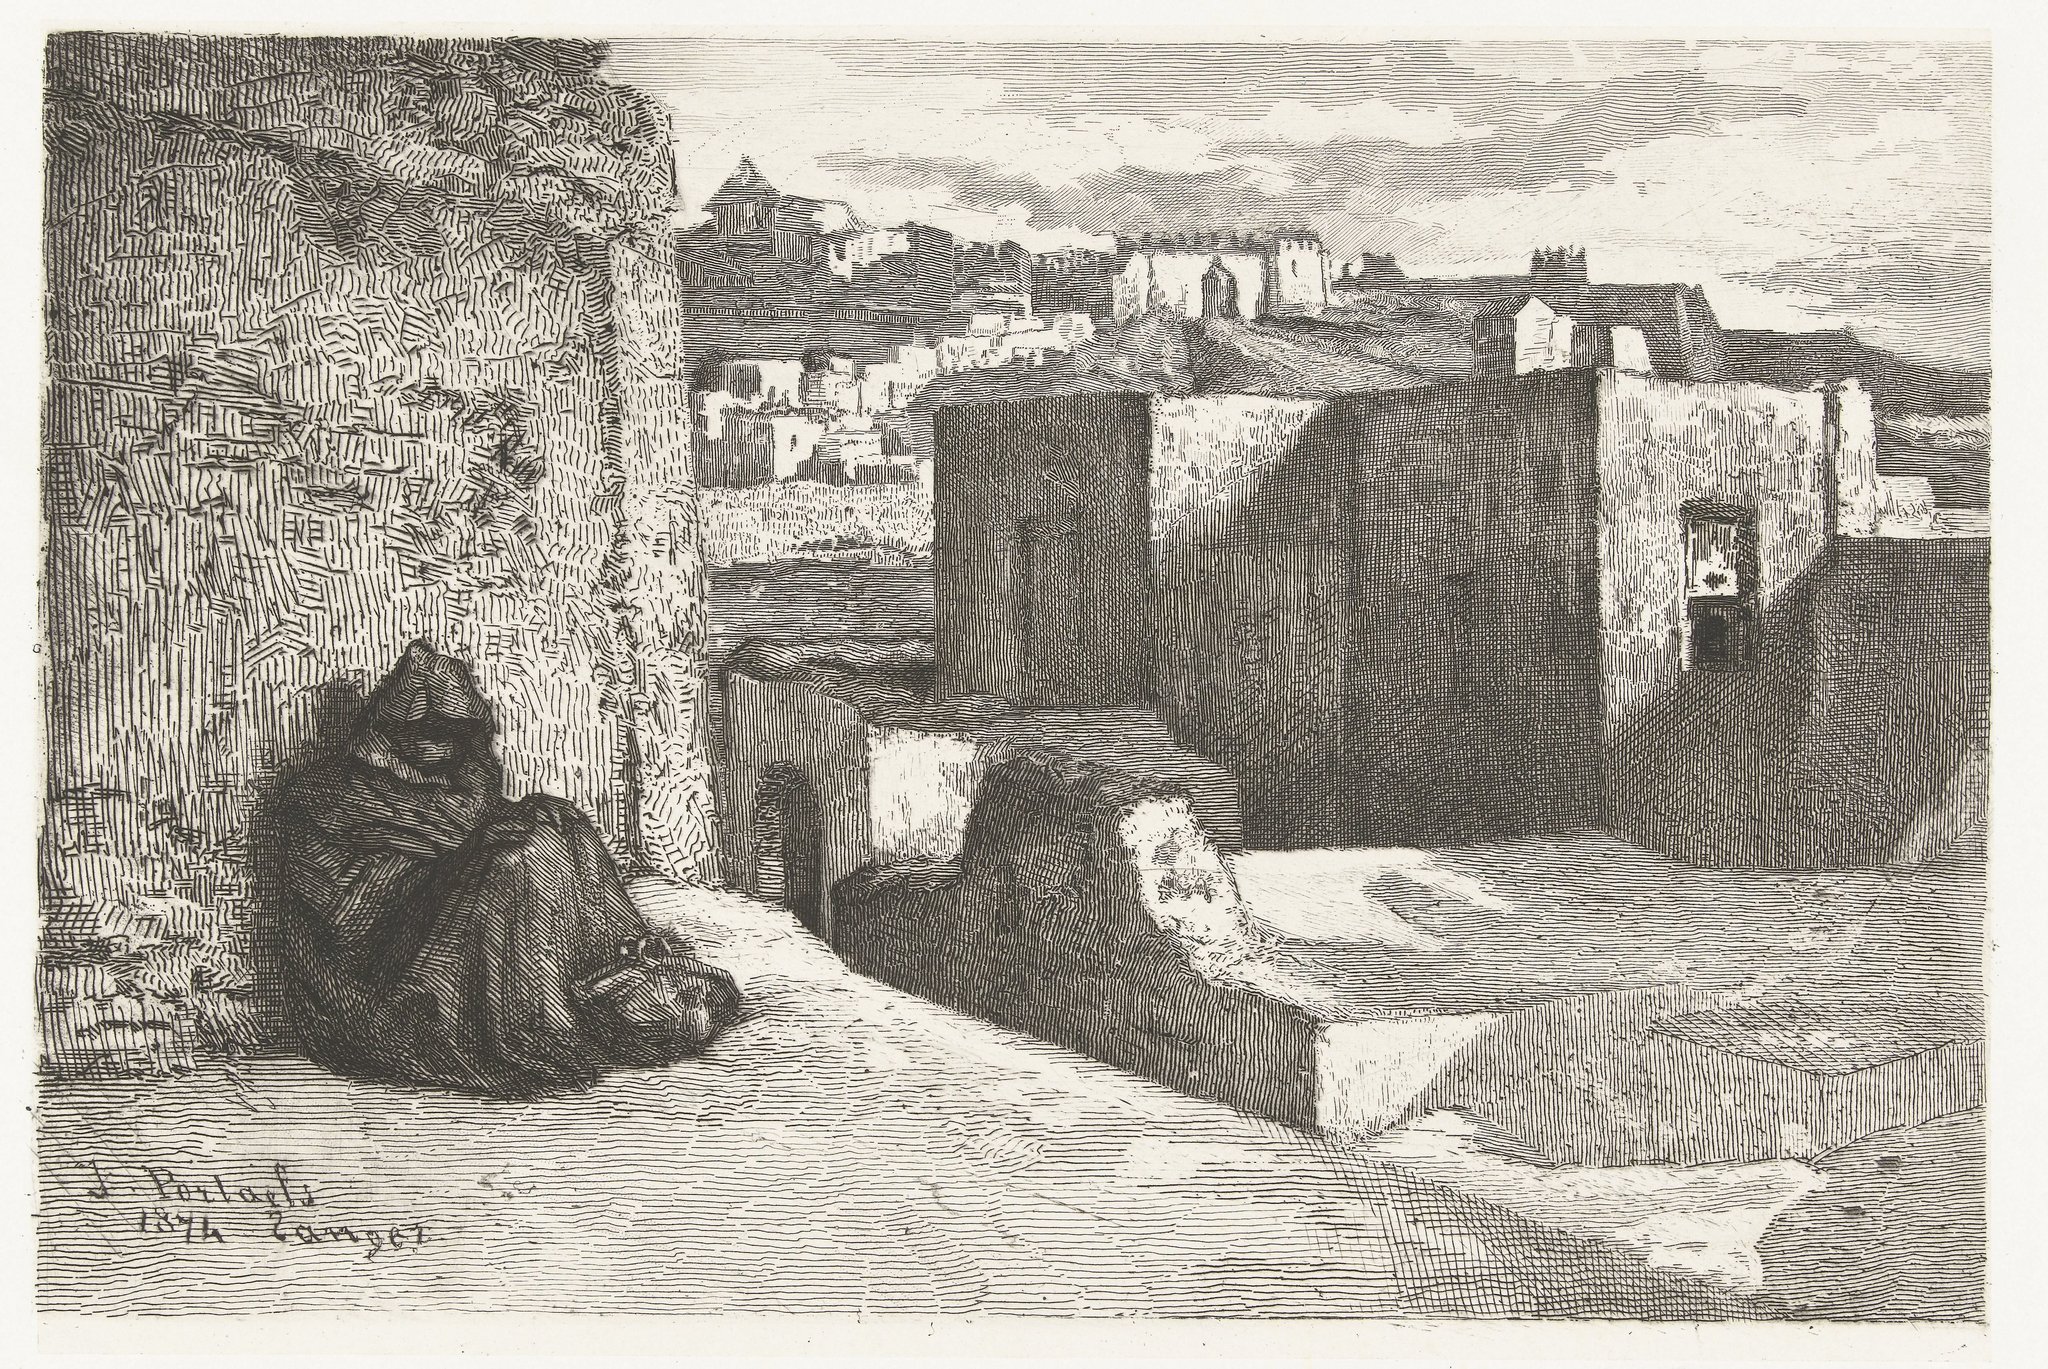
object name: print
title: Gezicht op Tanger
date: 1874-1909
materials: paper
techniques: etching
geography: netherlands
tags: tanger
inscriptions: collector's mark: Lugt 2228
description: Gezicht op de stad Tanger, links op de voorgrond zit een in een cape gehulde man tegen een muur geleund.